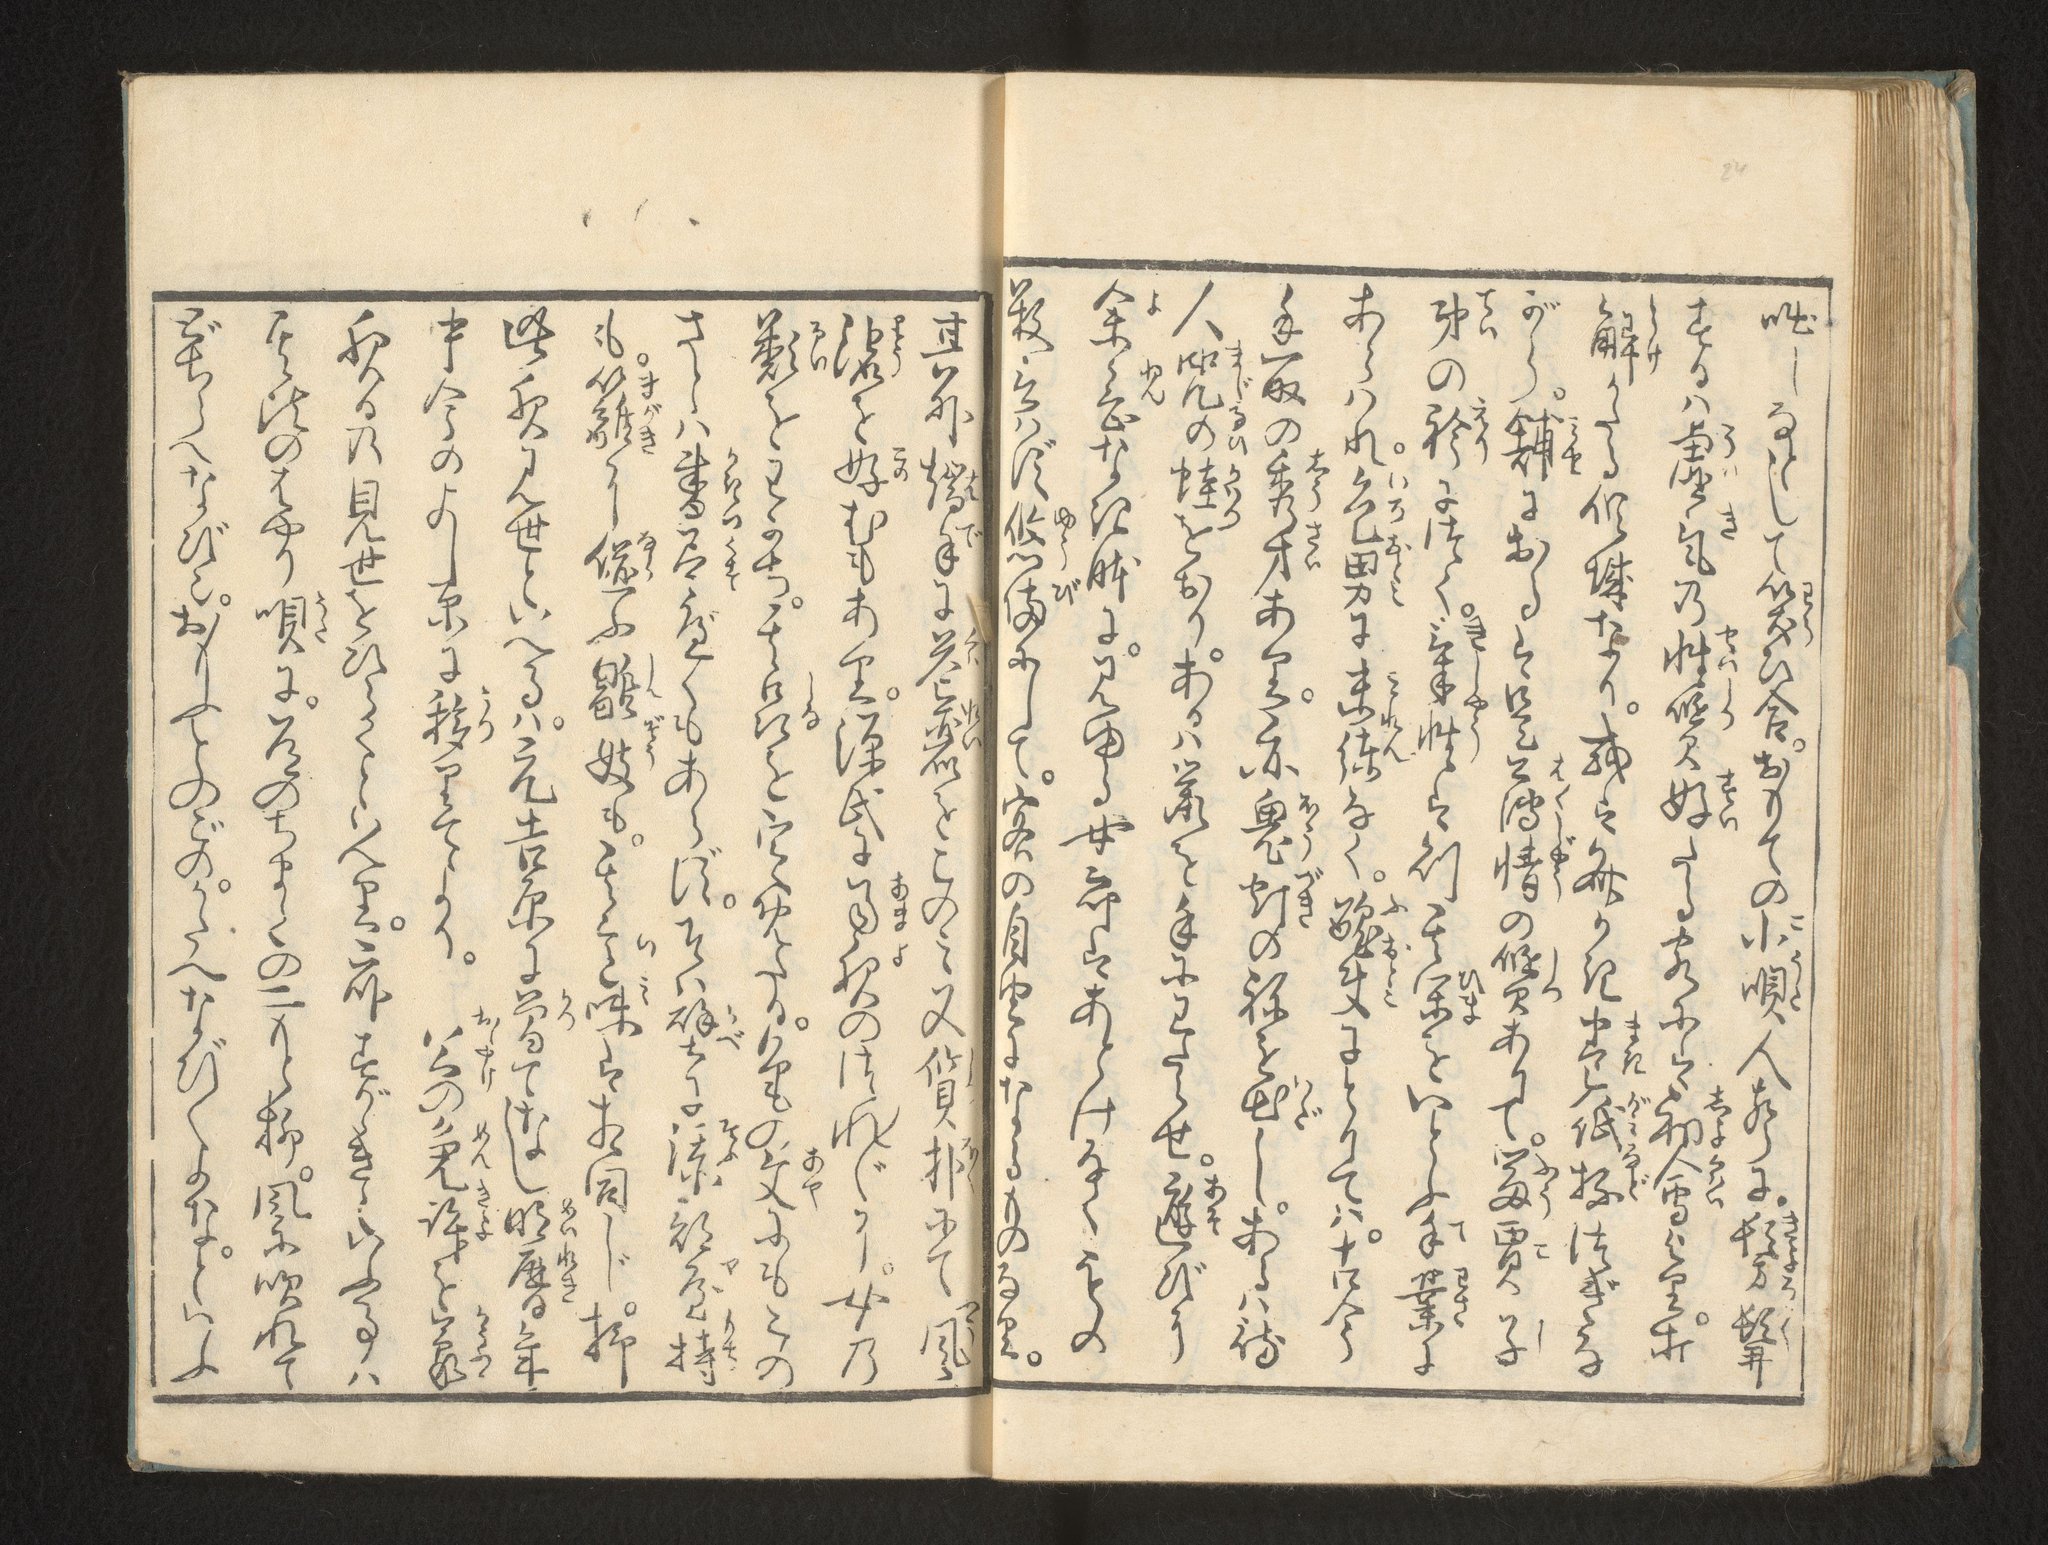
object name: page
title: Tekst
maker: jippensha ikku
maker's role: schrijver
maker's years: 1765-1831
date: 1804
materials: paper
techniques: woodcut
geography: edo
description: Pagina 46 en 47 van deel één van Utamaro`s boek: Gebeurtenissen in de lusthuizen gedurende het jaar.